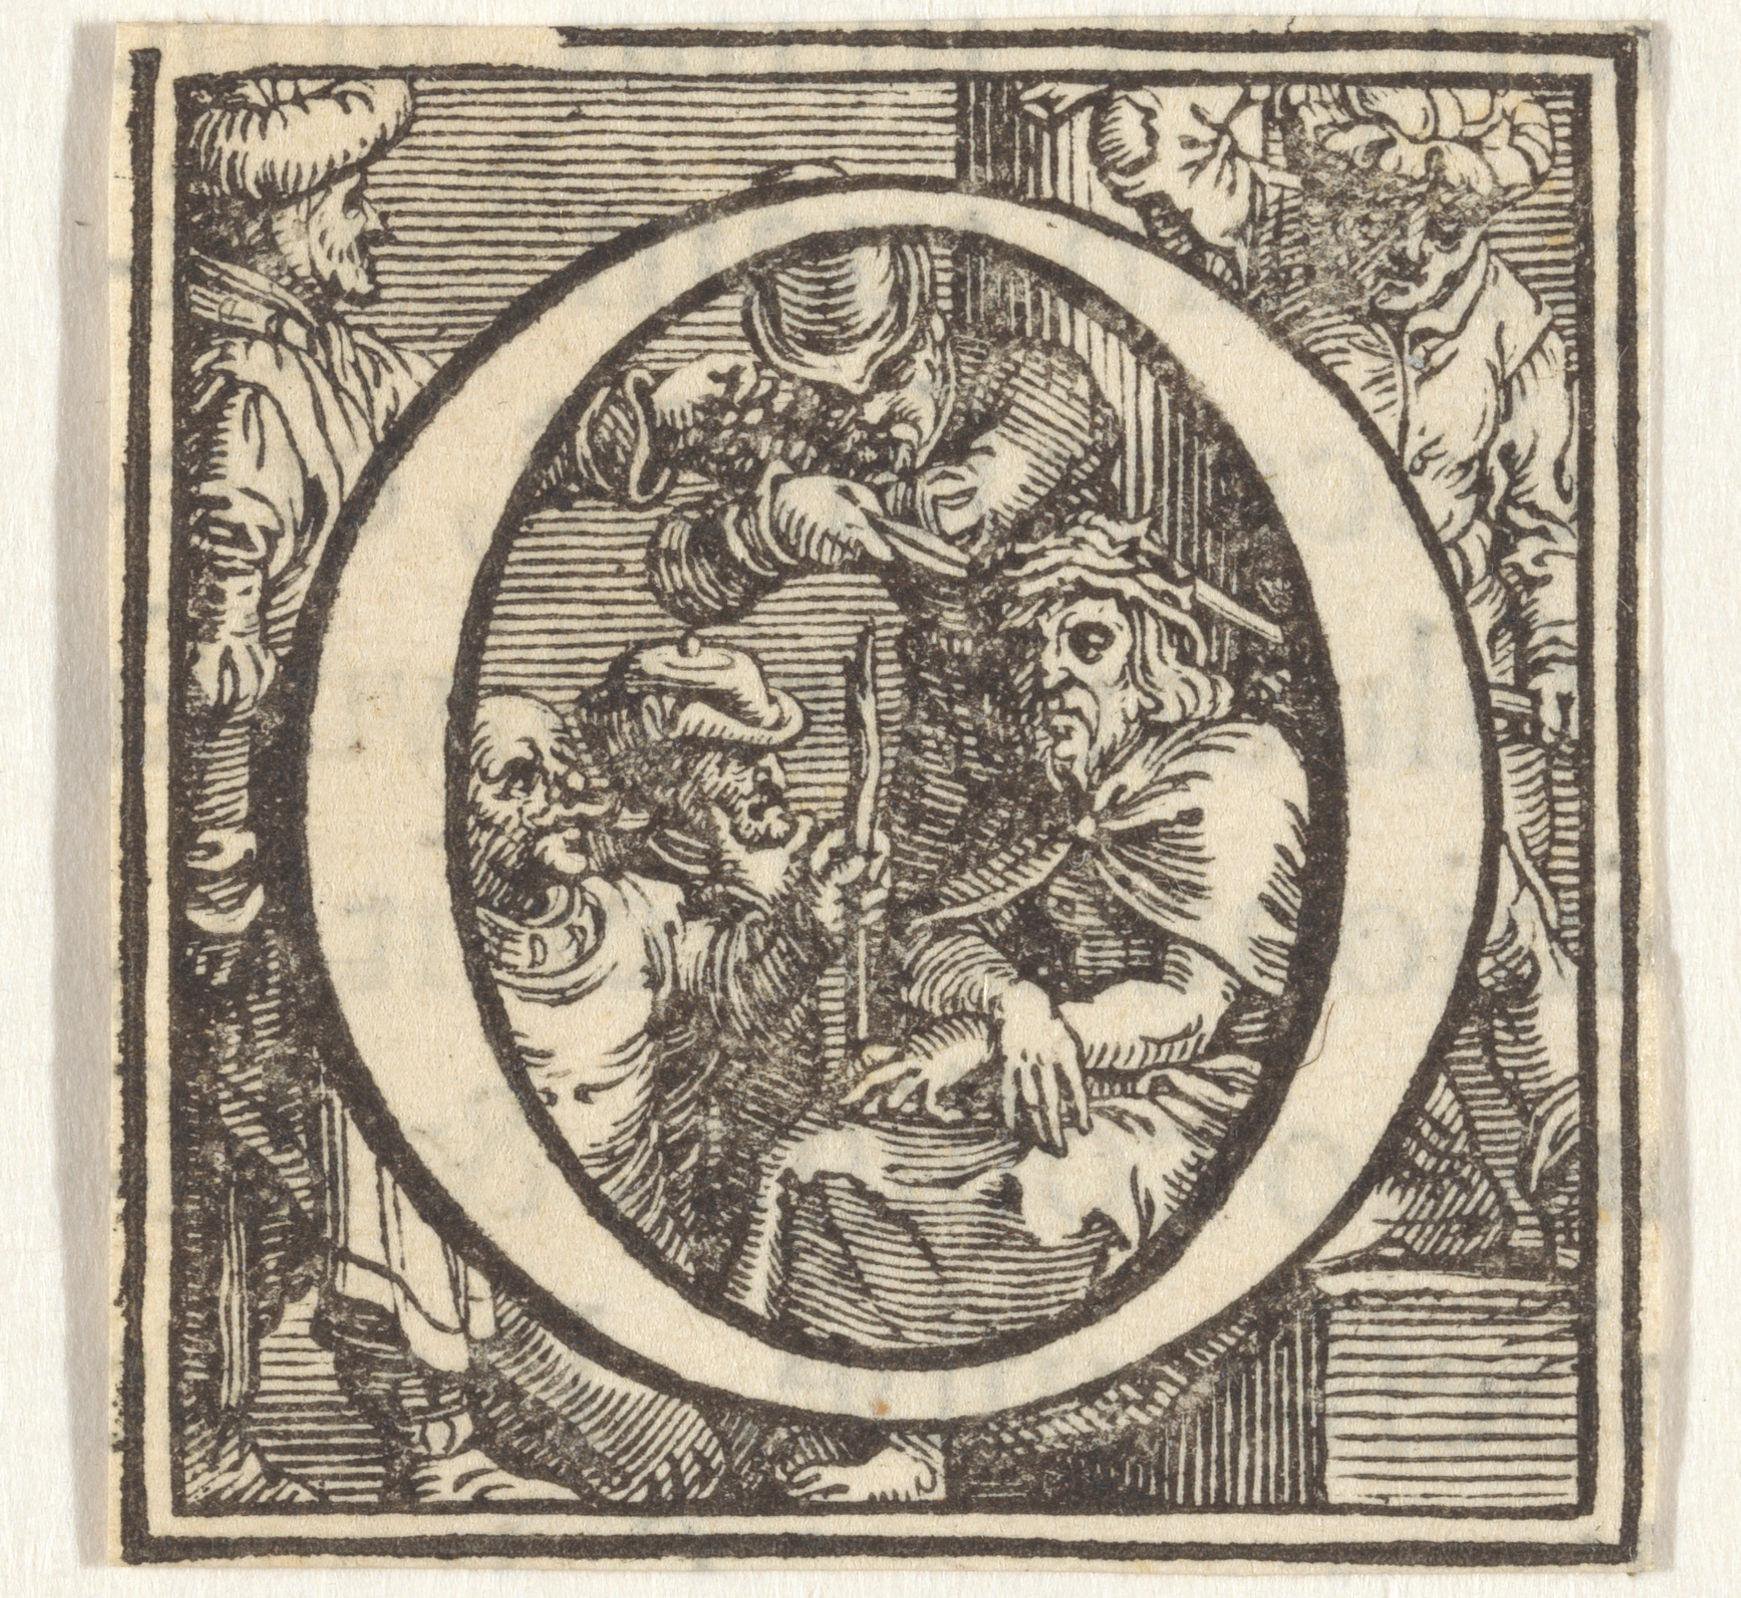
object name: book illustration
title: Letter O in een omlijsting met een voorstelling van de doornenkroning van Christus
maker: Anonymous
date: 1600-1699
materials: paper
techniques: letterpress printing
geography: netherlands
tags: fancy letters, the crowning with thorns: soldiers with sticks place a thorny crown on christ's head and give him a reed (matthew 27:27-31; mark 15:16-20; john 19:2-3)